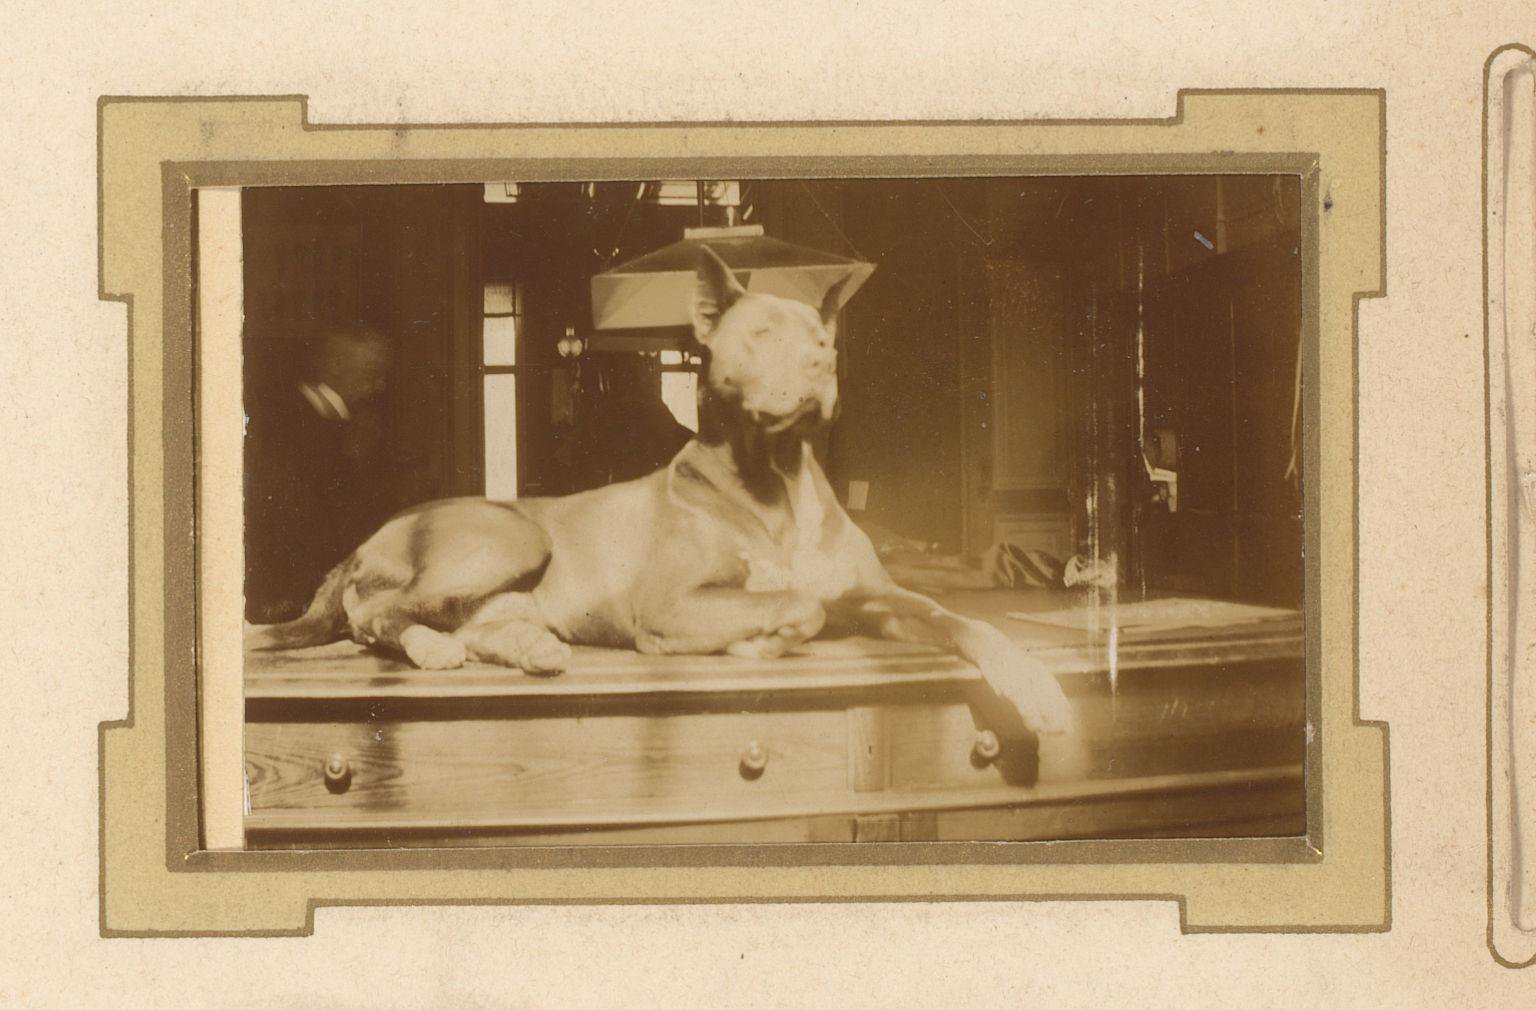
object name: carte de visite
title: Hond liggend op tafel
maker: Anonymous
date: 1880-1920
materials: cardboard, photographic support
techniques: gelatin silver print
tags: dog